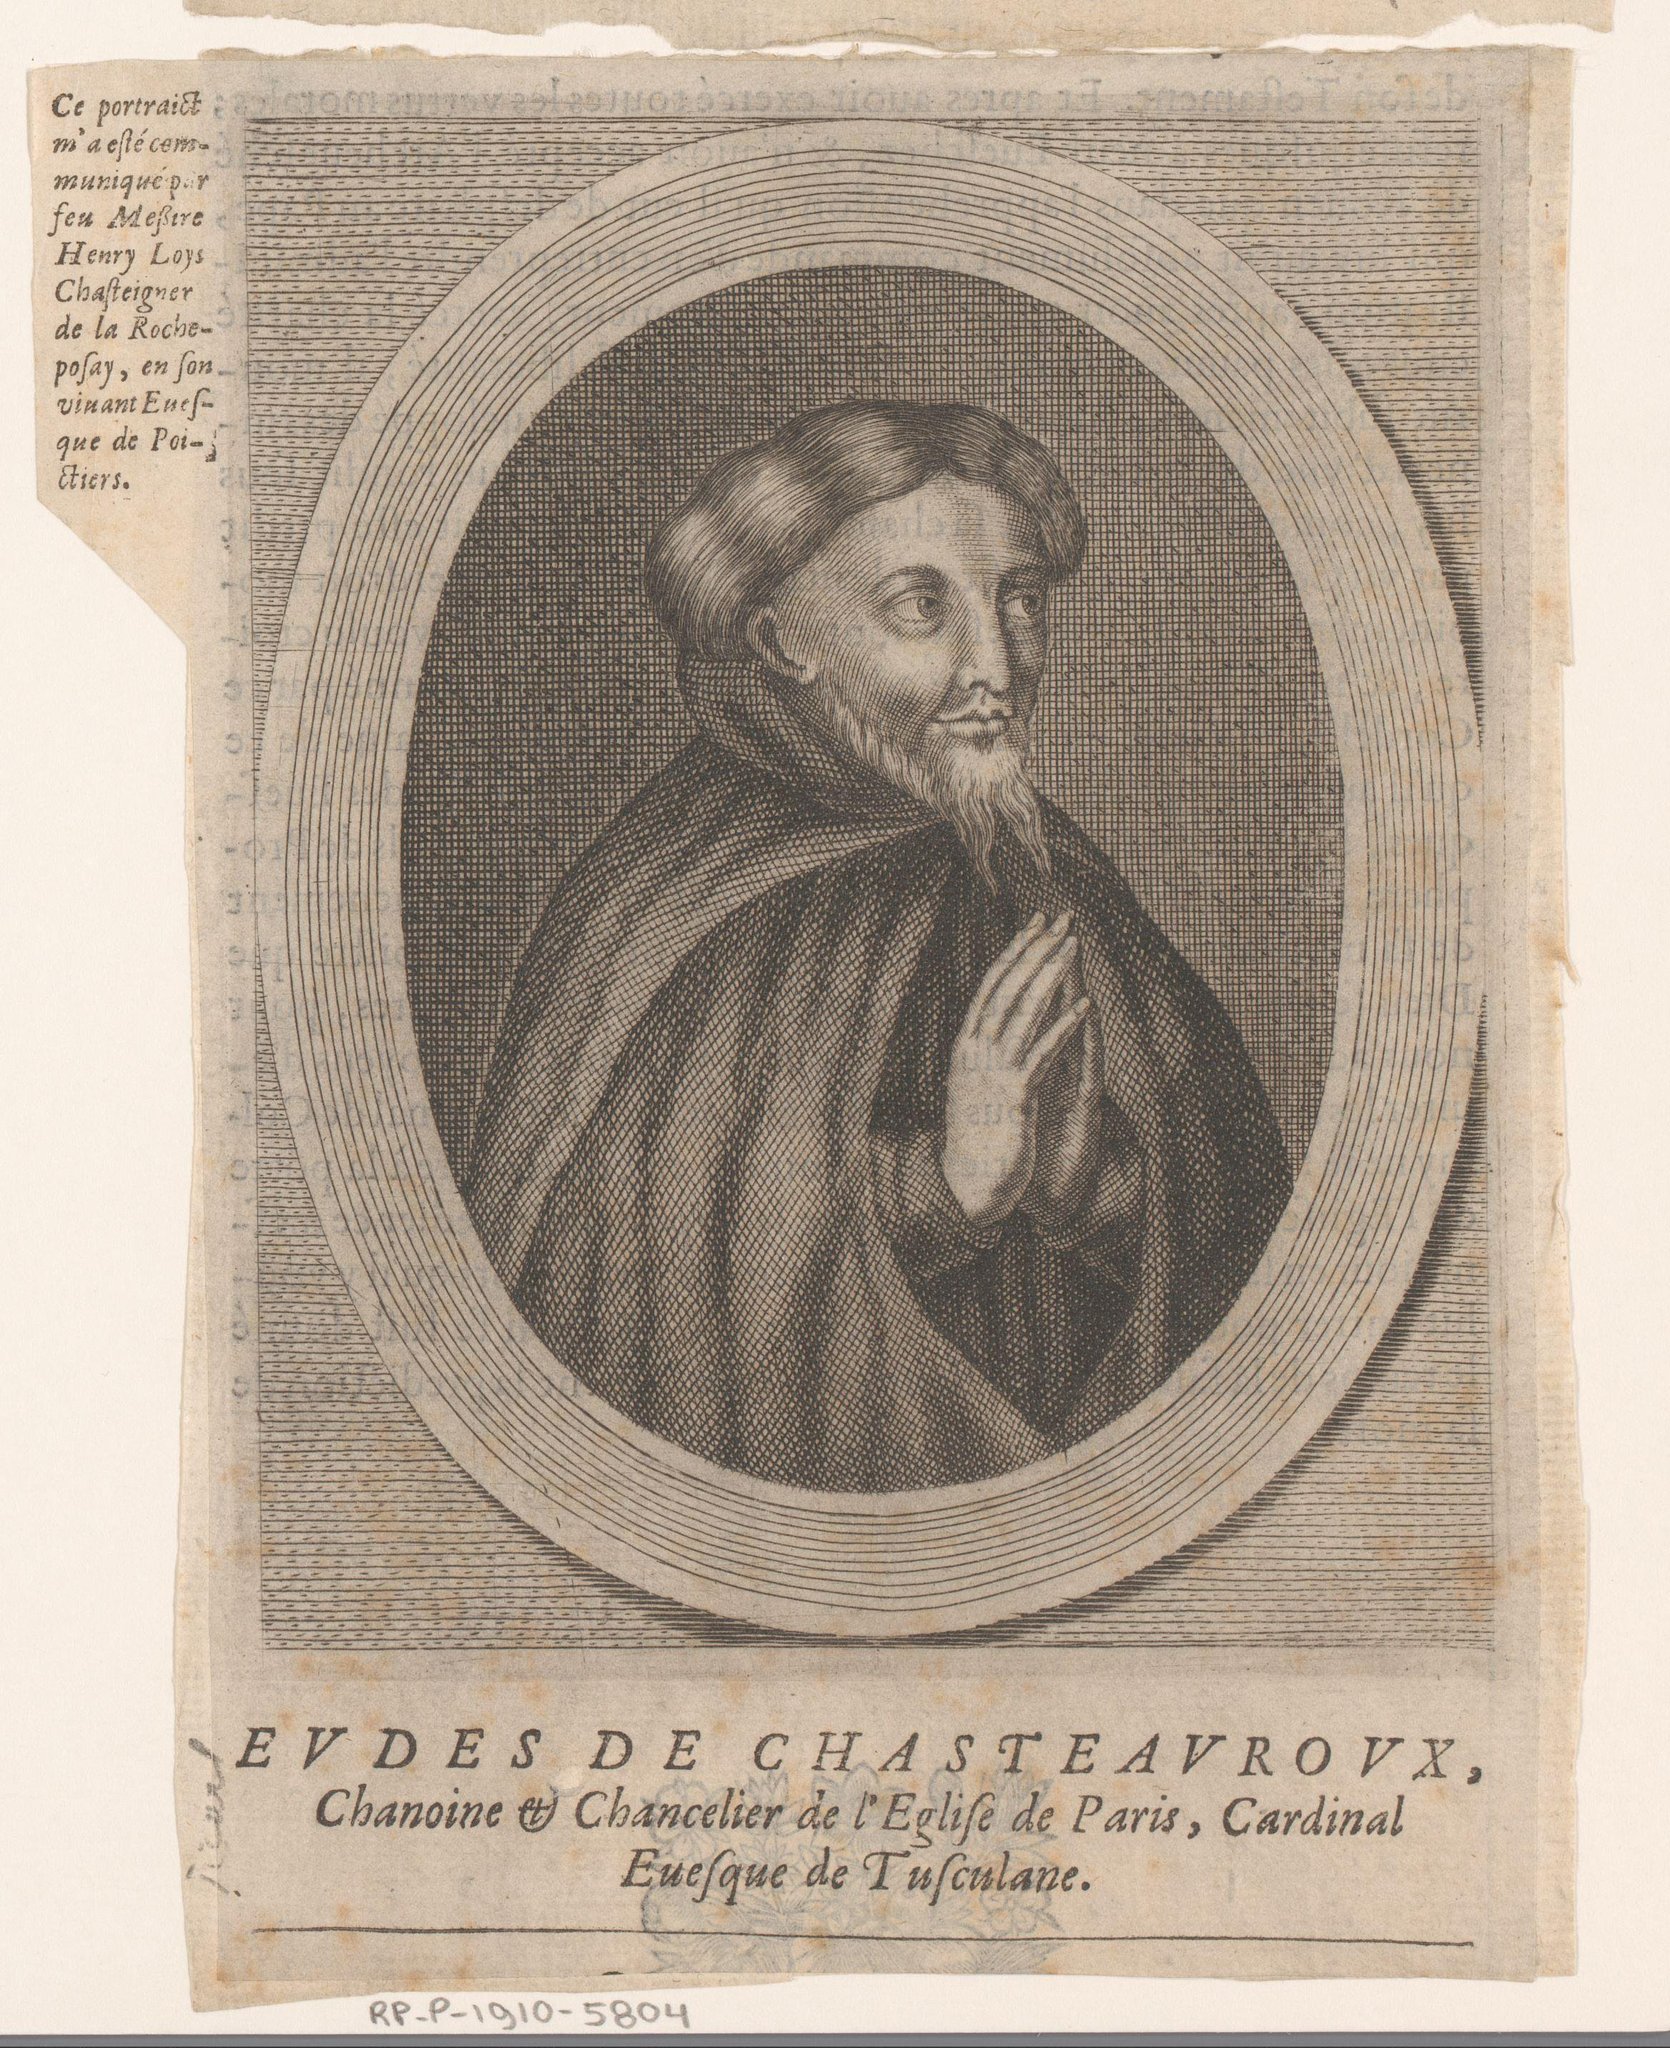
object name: book illustration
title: Portret van Eudes de Chasteauroux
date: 1660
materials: paper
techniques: engraving, etching, letterpress printing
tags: cardinal, historical persons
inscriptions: collector's mark: Lugt 2228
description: Prent uit: Du Chesne, François. Histoire de tous les cardinaux françois de naissance, ou qui ont esté promeus au cardinalat. Parijs: François Du Chesne, 1660.